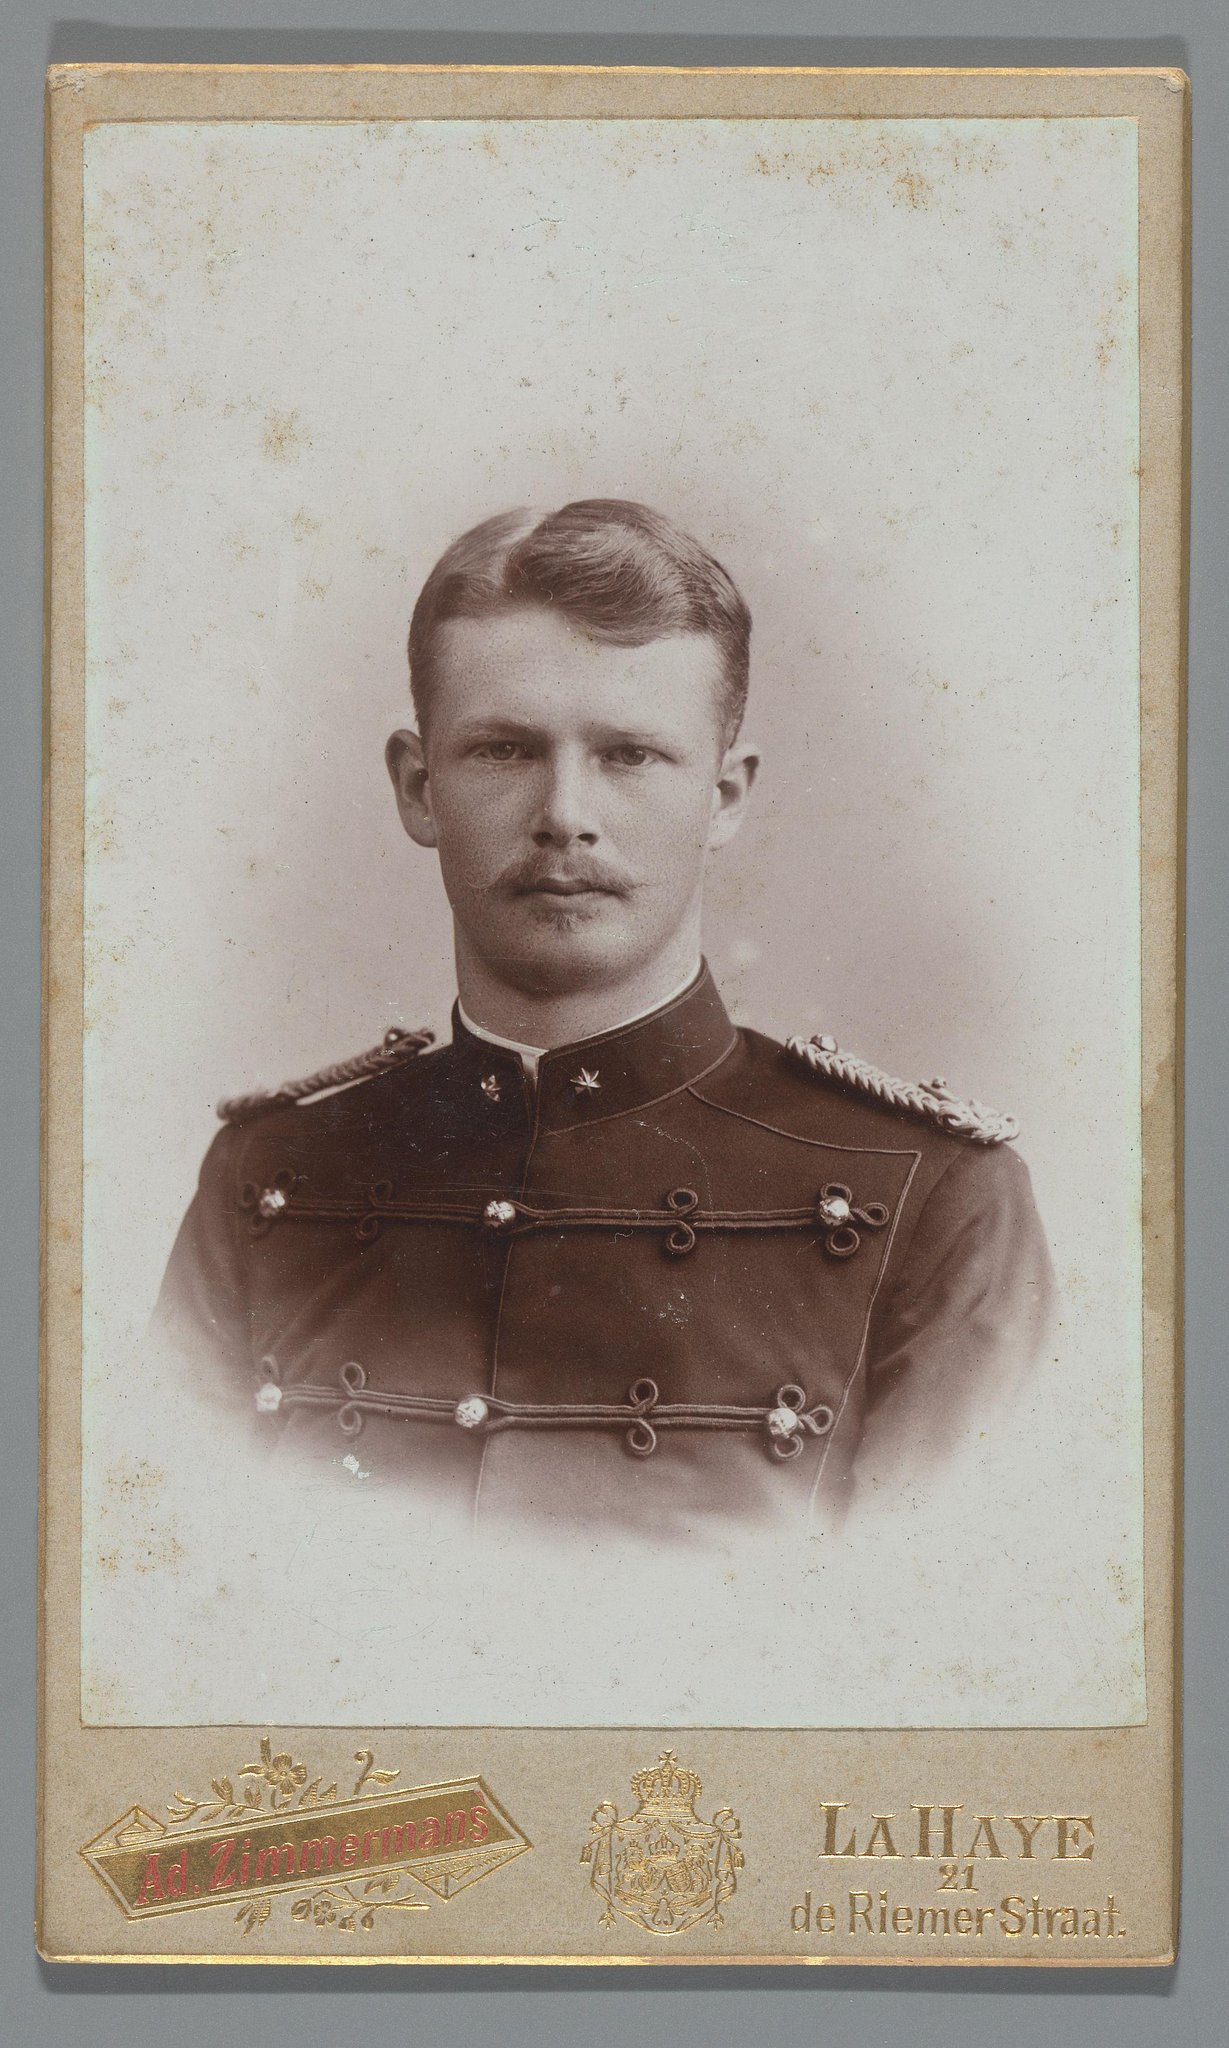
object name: carte de visite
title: Portret van G.L.J. Holle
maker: adolphe zimmermans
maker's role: fotograaf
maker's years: 1858-1922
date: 1870-1920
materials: cardboard, photographic support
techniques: albumen print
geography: the hague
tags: g.l.j. holle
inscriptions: name: ‘G.L.J. Holle’, name: ‘Ad. Zimmermans LA HAYE / 21 / de Riemer Straat.’